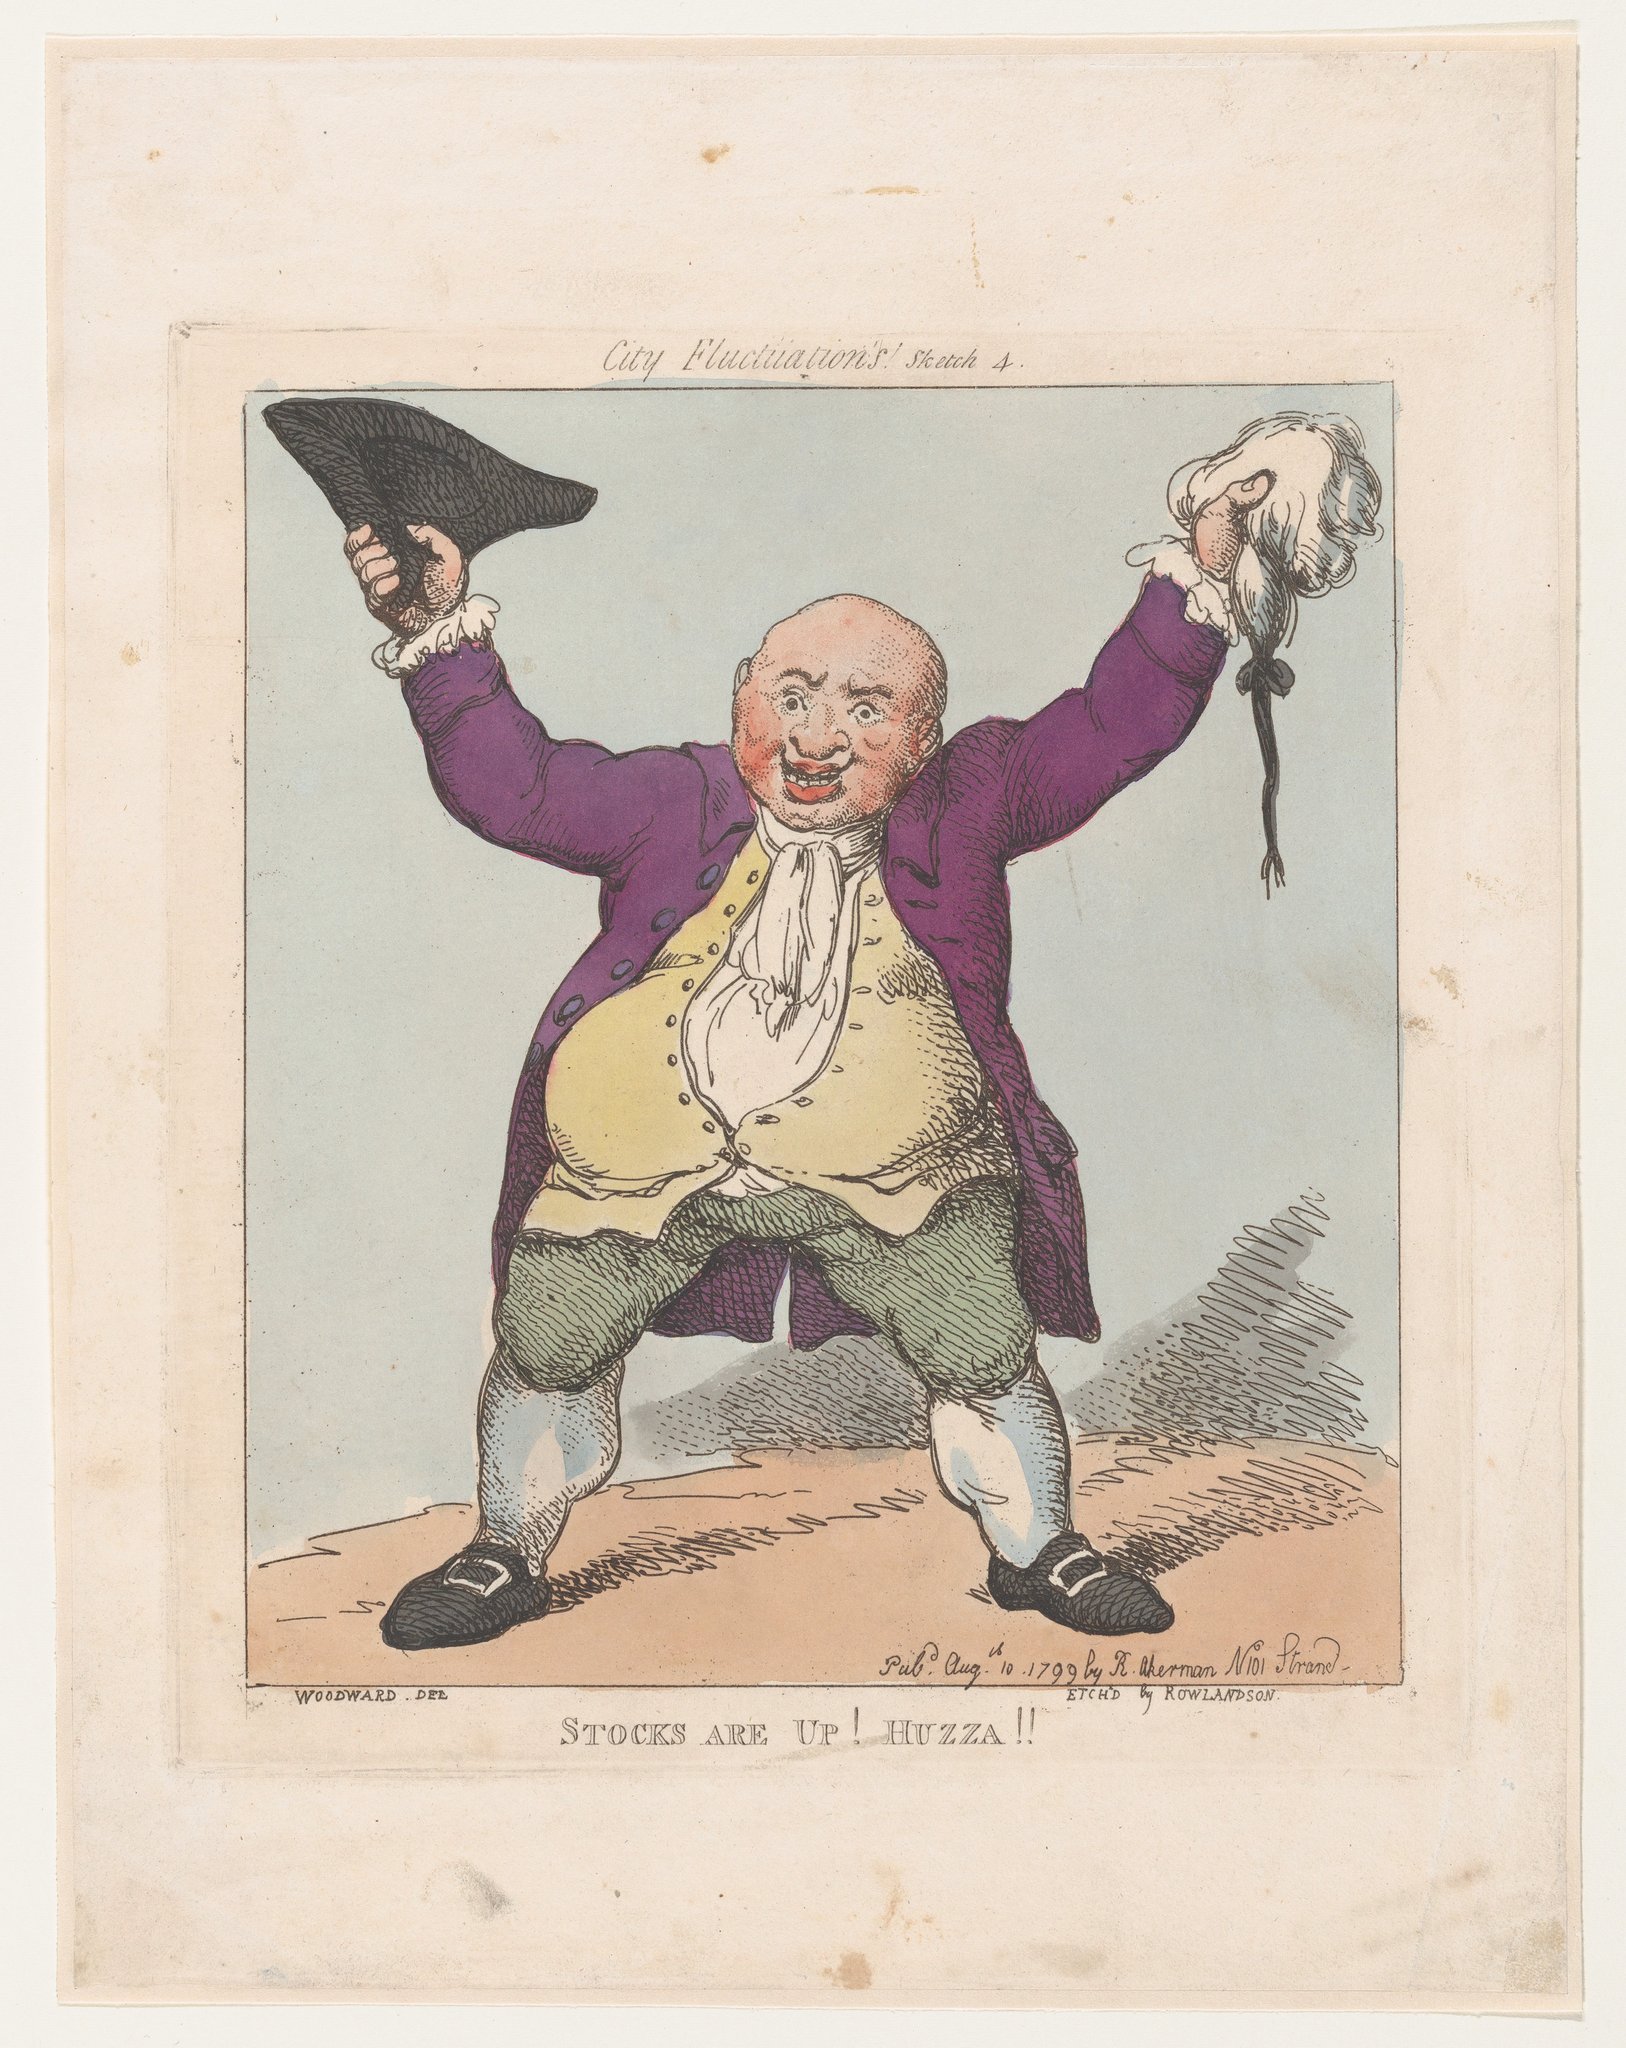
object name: print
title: Stocks Are Up! Huzza!!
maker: thomas rowlandson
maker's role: artist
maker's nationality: british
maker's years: 1757-1827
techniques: etching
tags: men